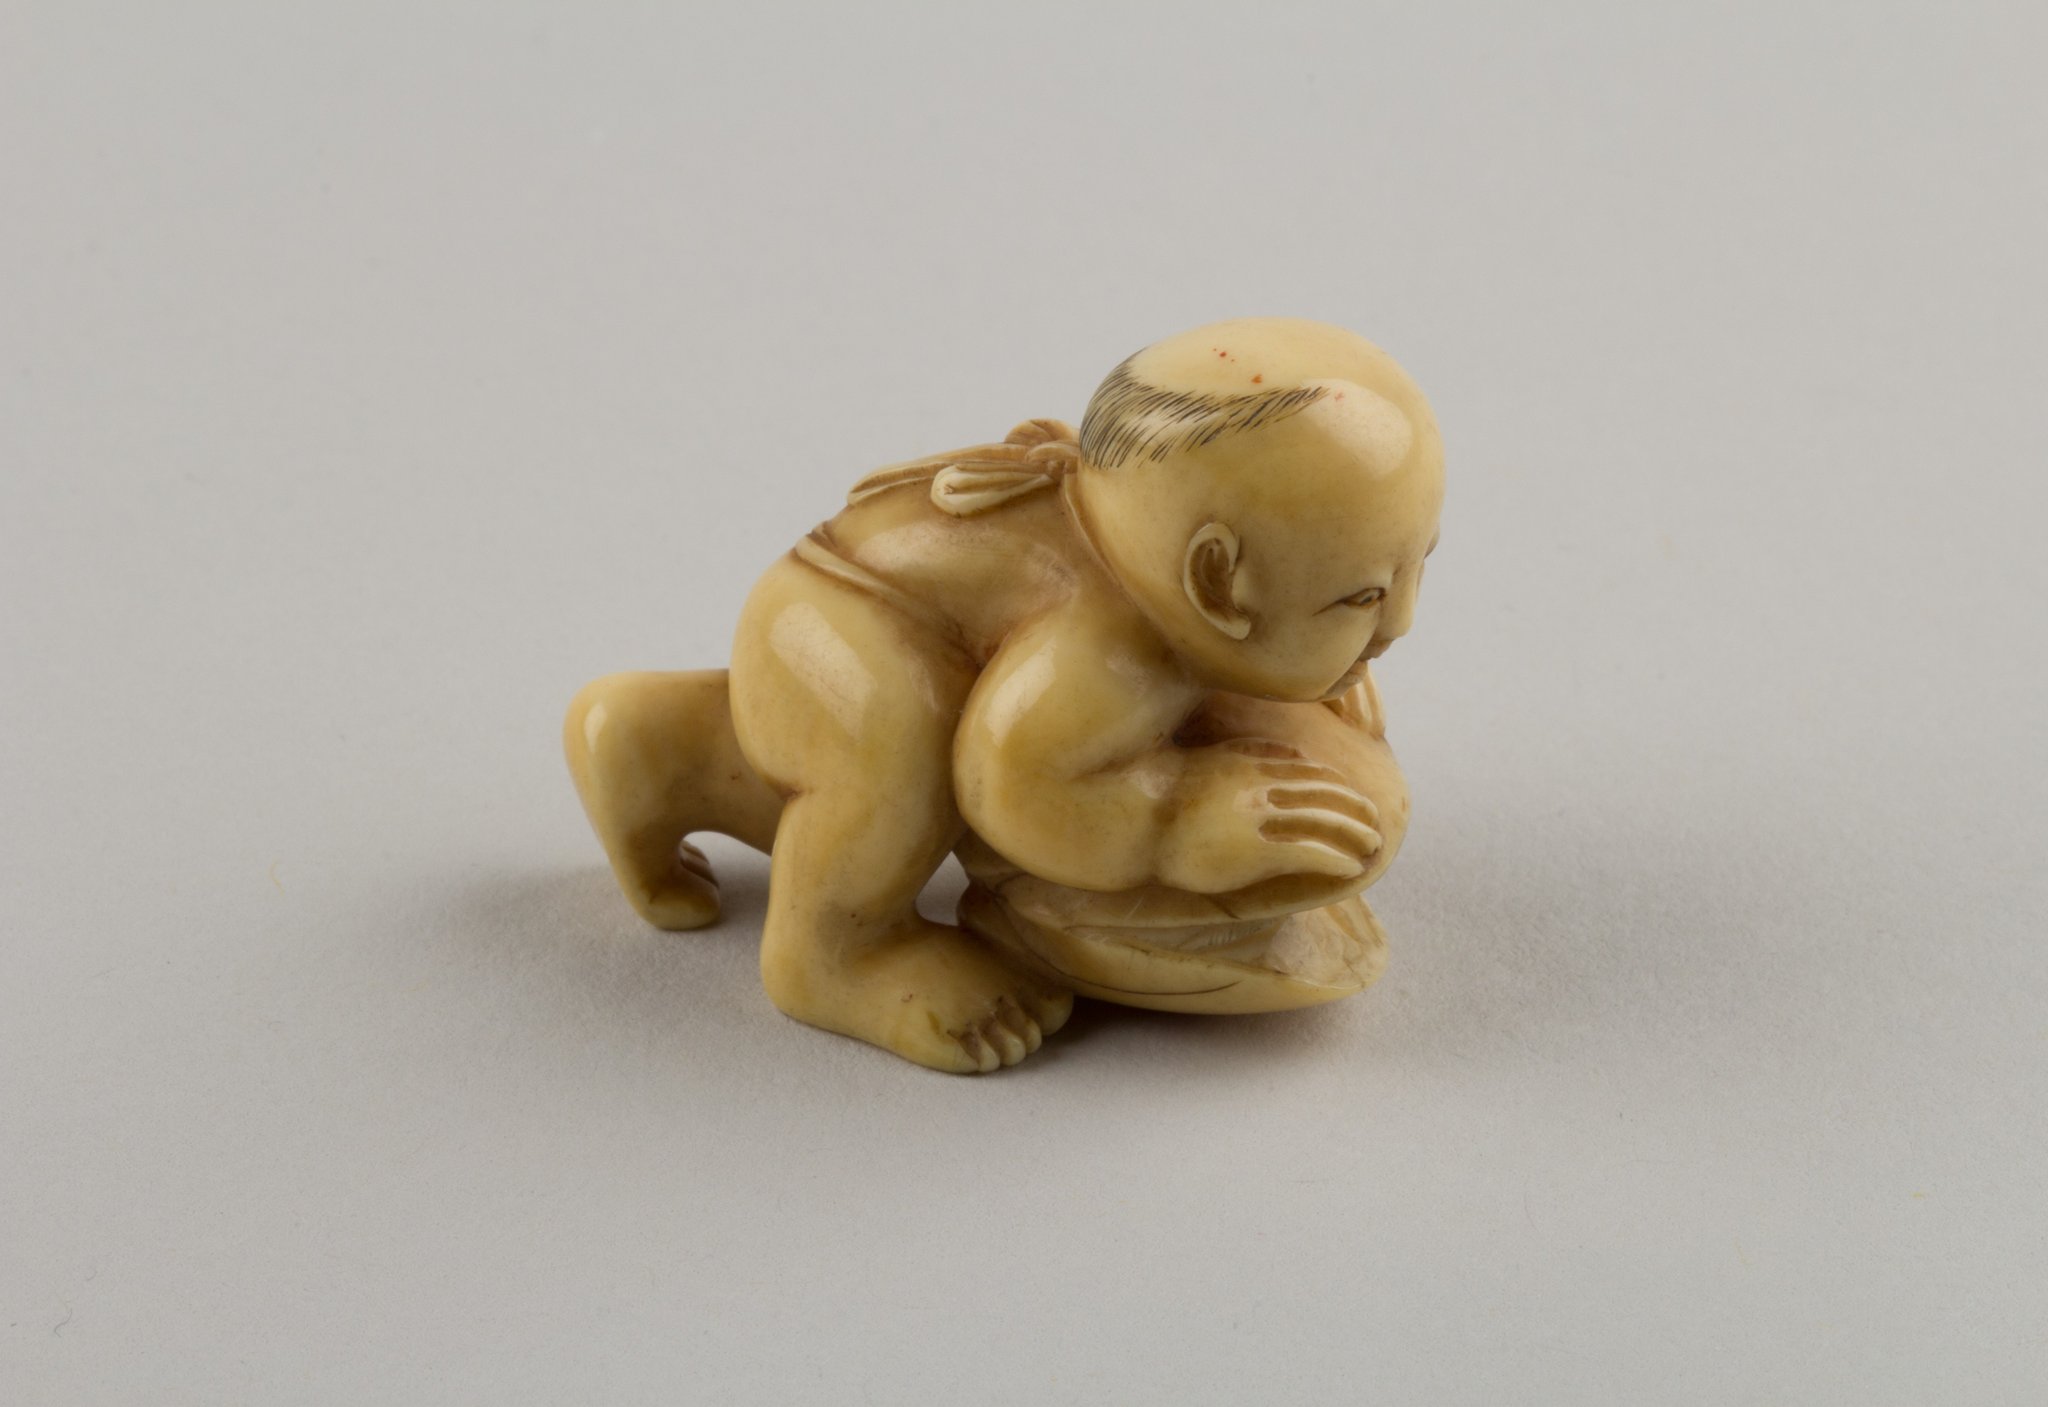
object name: netsuke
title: Netsuke of Child with a Shell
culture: japanese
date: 1801-1900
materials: ivory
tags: children,shells